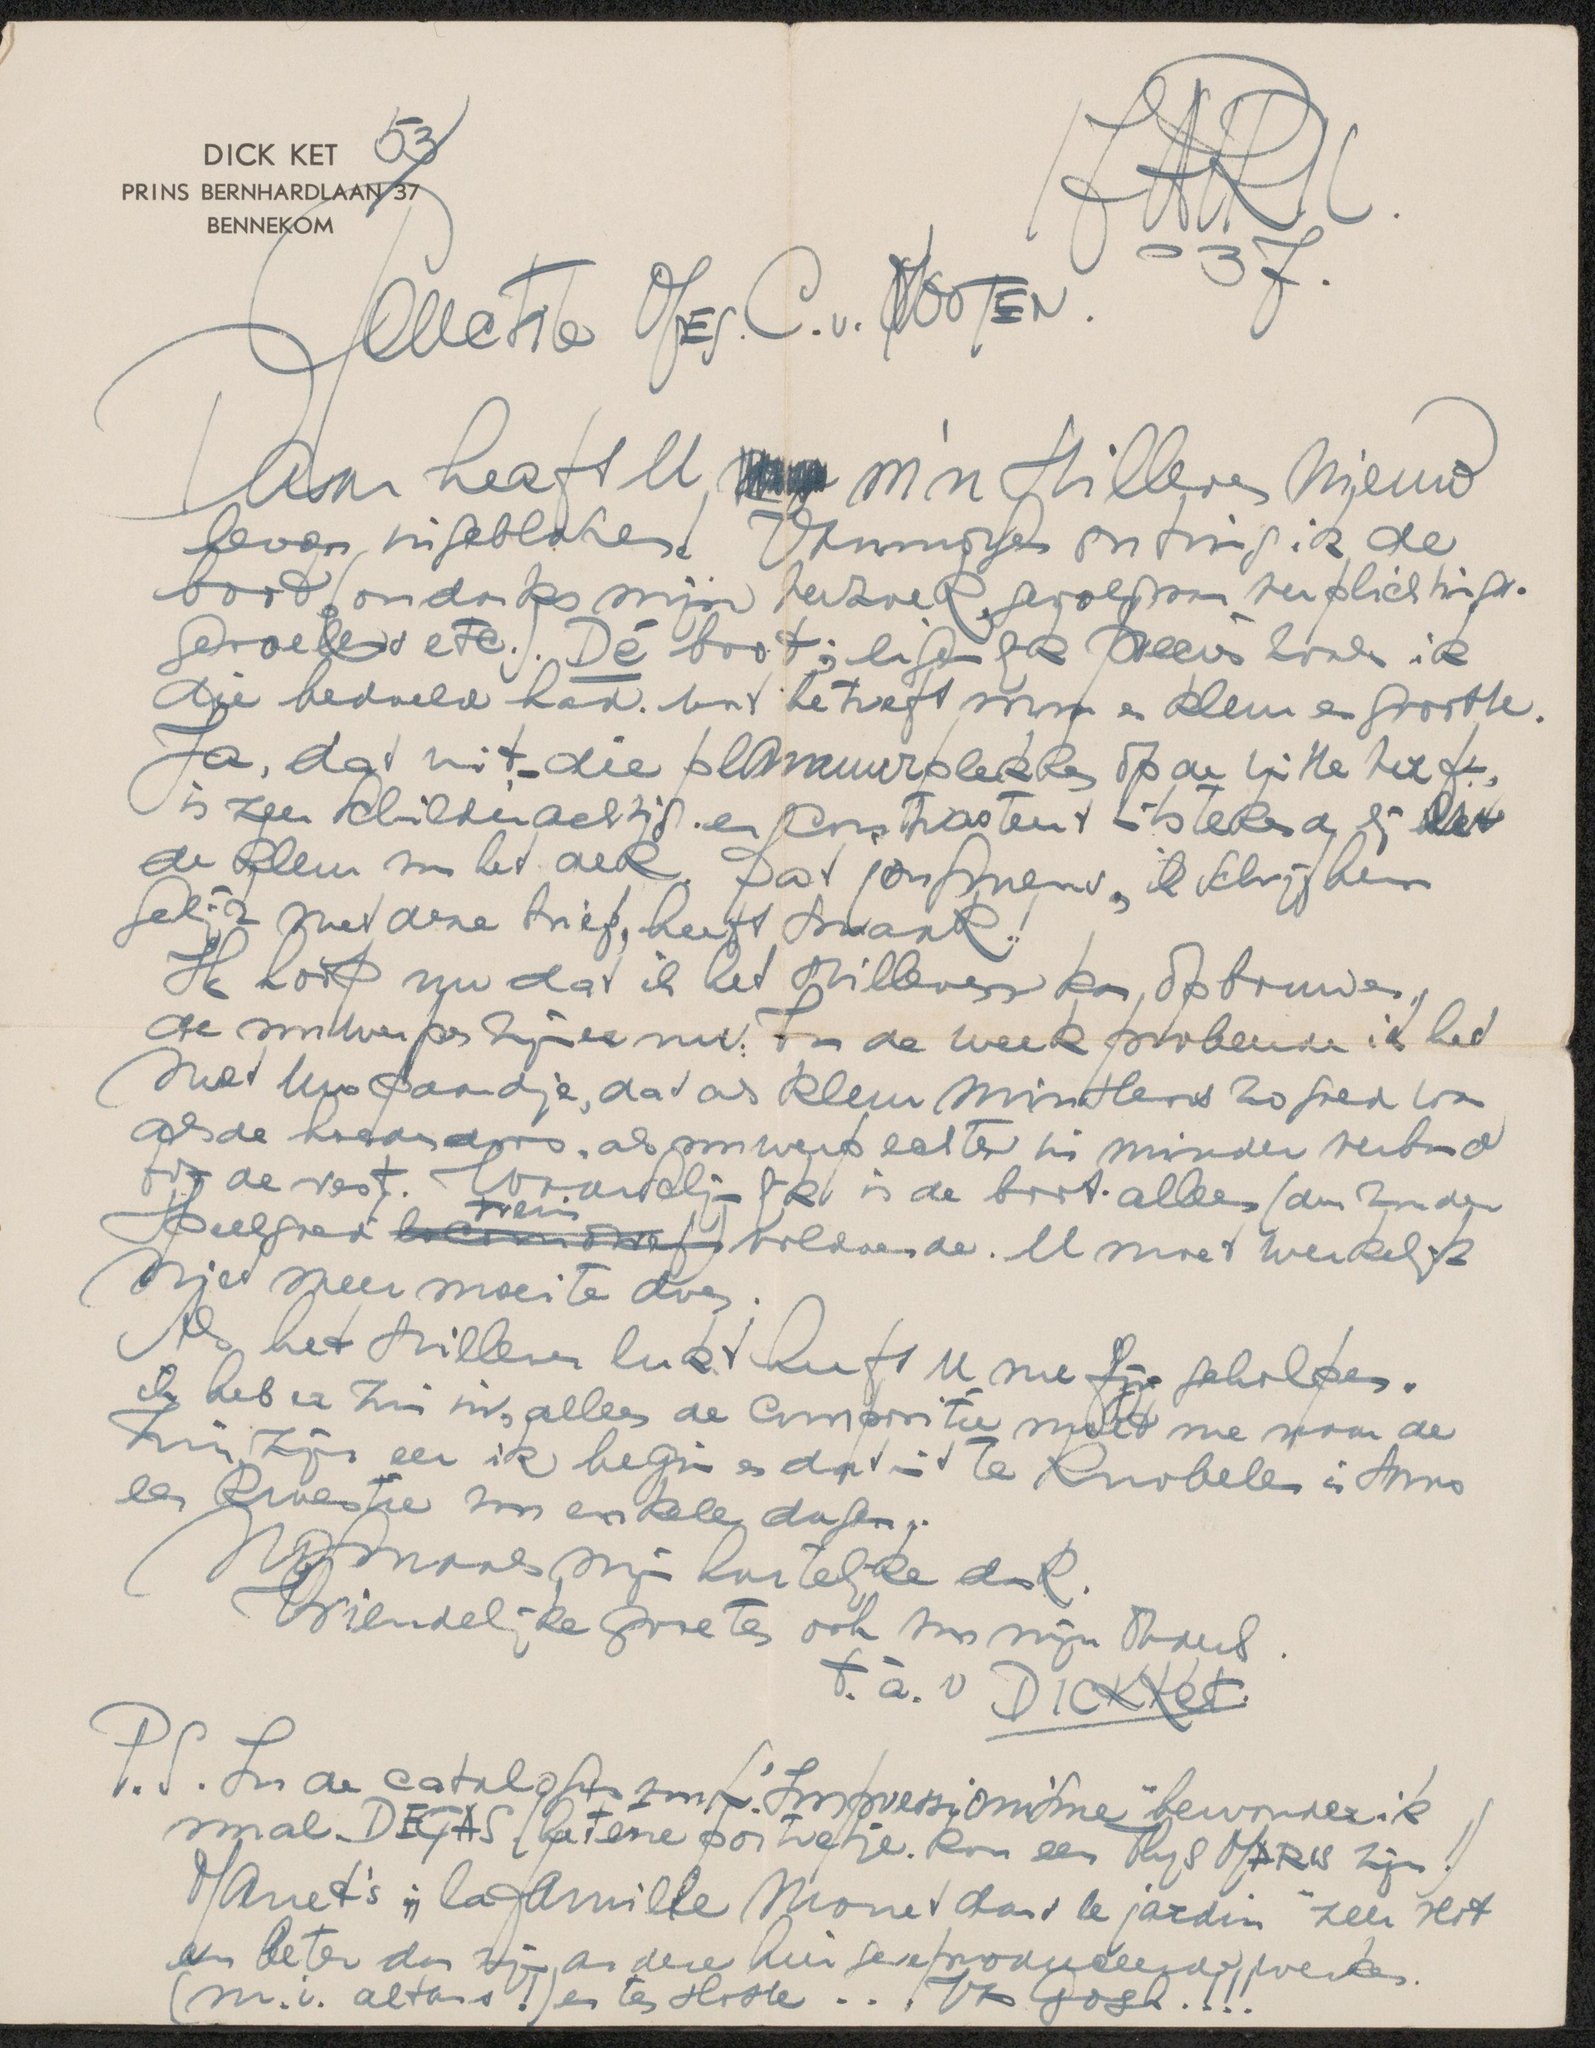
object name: letter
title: Brief aan Mien Cambier van Nooten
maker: dick ket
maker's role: draughtsman, print maker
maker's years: 1902-1940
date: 1937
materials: ink, paper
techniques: pen, printing, writing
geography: bennekom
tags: london, matthijs maris, vincent van gogh, arnhem, print maker, draughtsman, mien cambier van nooten, edouard manet, paris, painter, sculptor, edgar degas, painting (including book-illumination, miniature-painting)